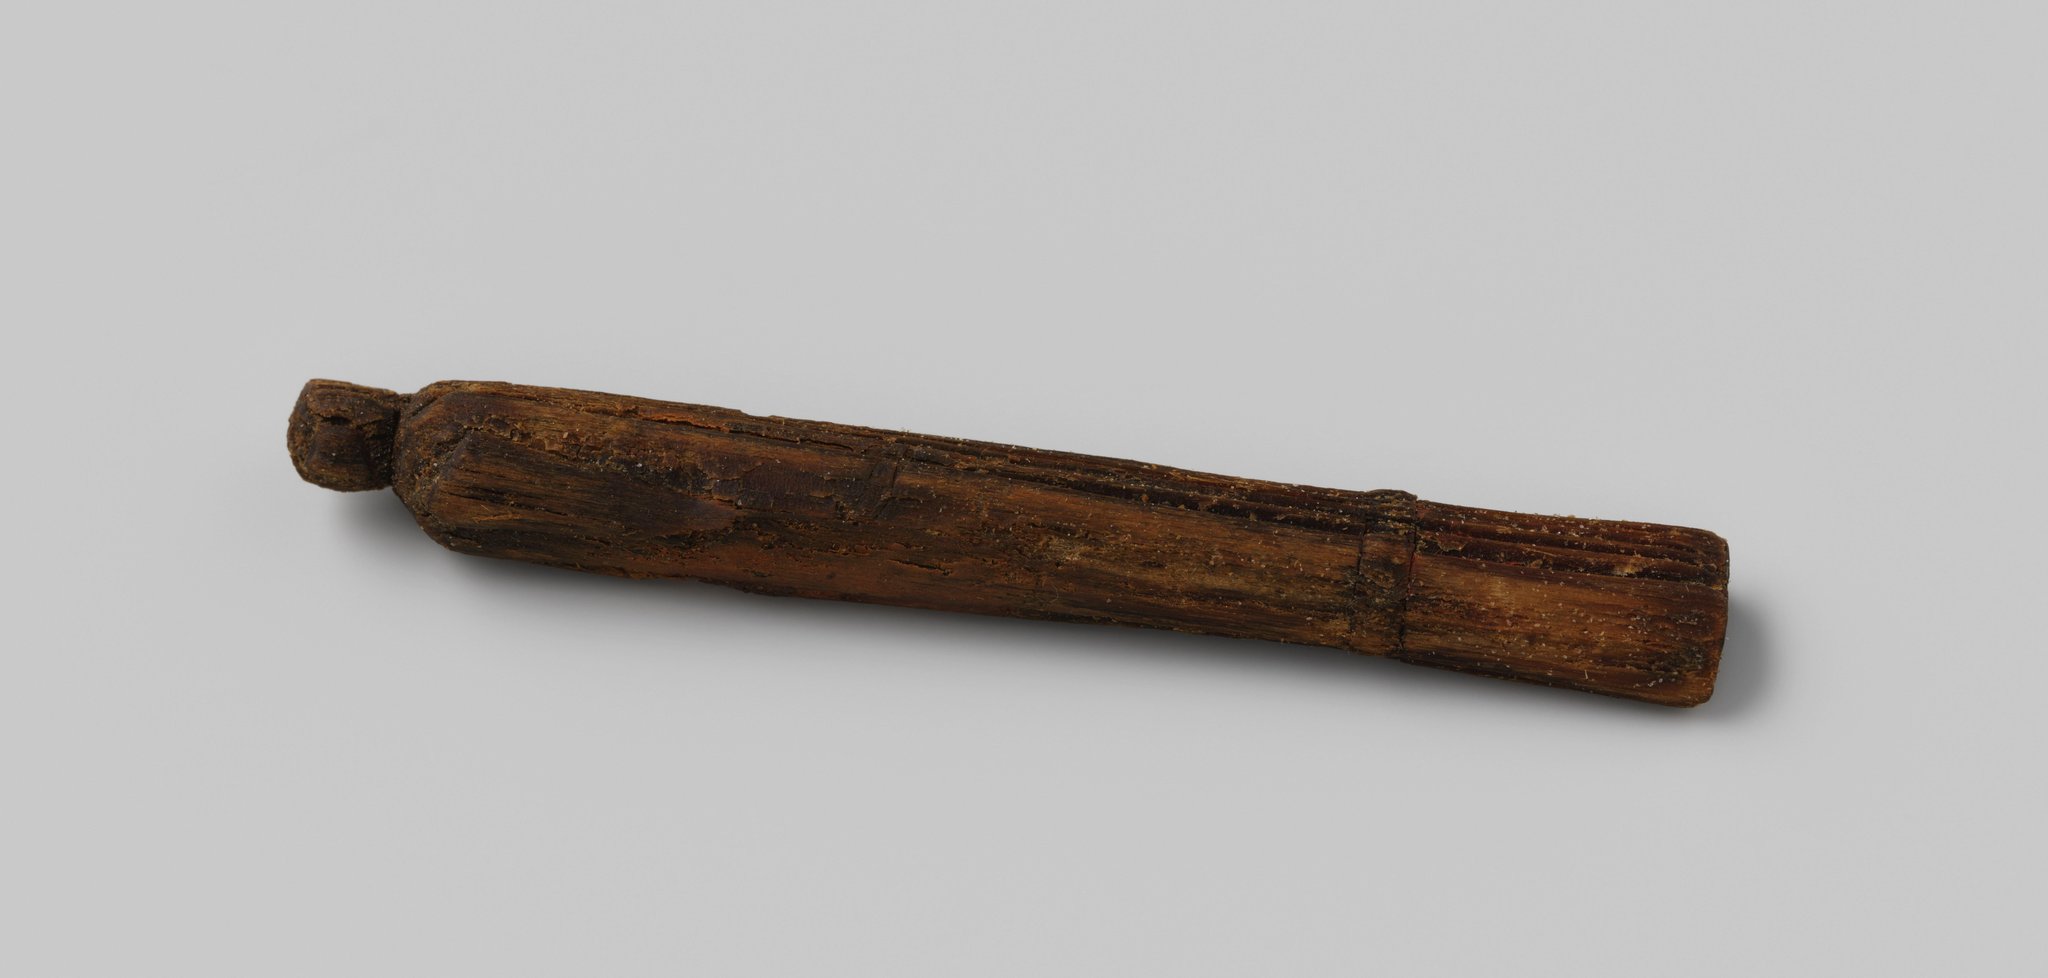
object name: helve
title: Houten steel uit het wrak van de Oost-Indiëvaarder Hollandia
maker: Anonymous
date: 1700-1743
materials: wood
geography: netherlands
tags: verenigde oostindische compagnie, hollandia (schip), annet